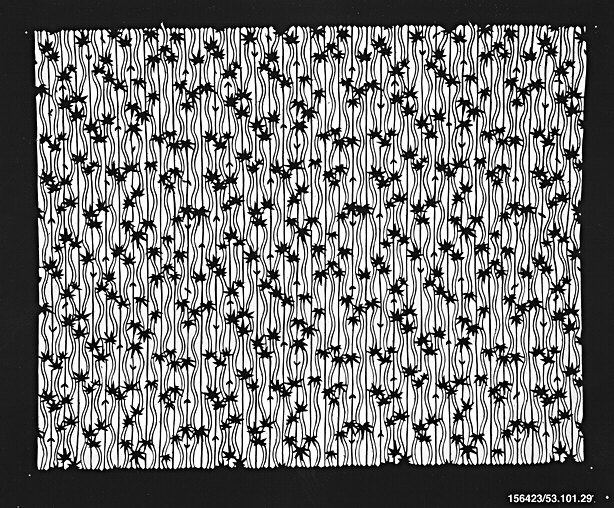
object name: stencil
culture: japanese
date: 1615-1868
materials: paper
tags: flowers